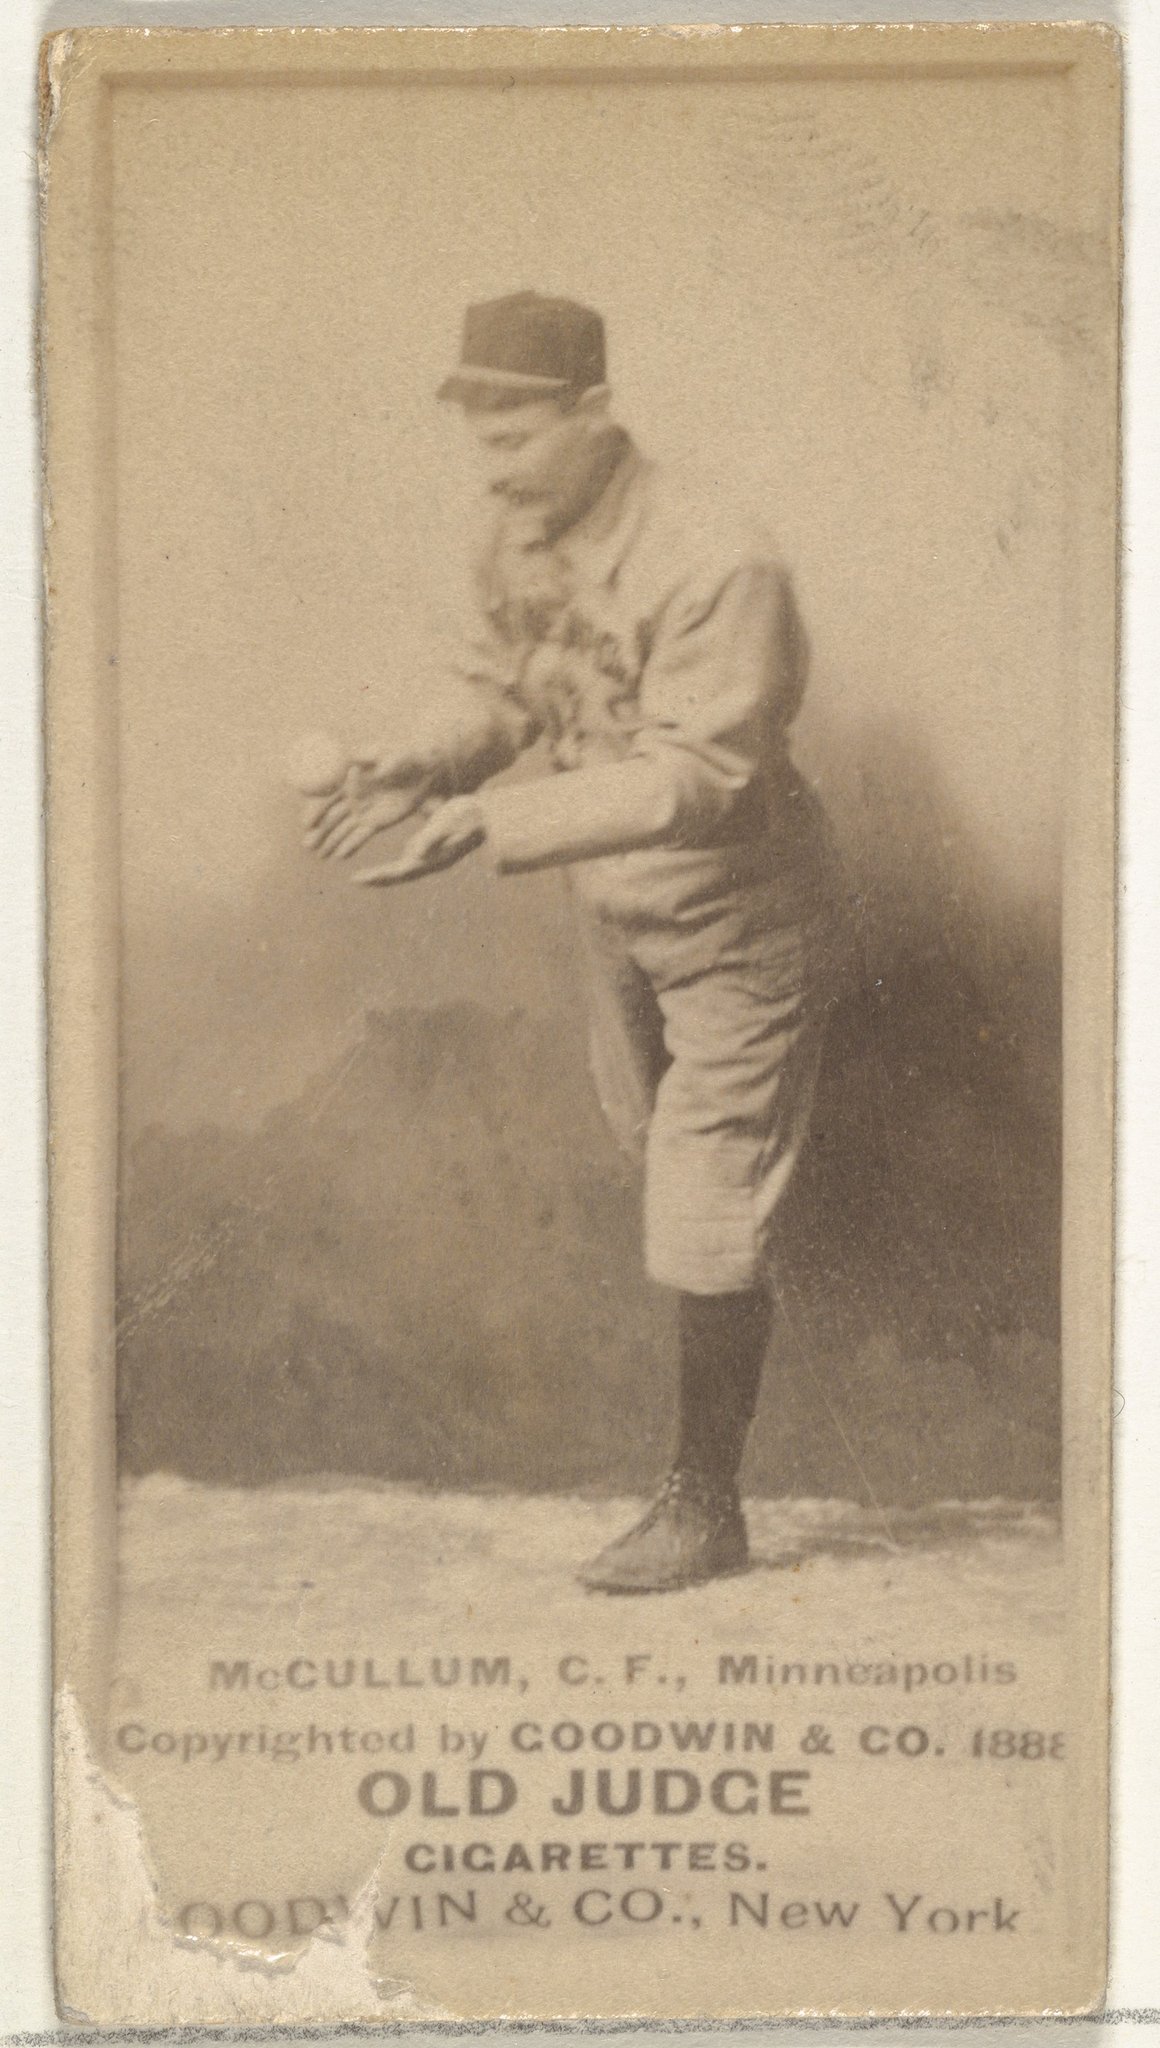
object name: baseball card, photograph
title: Thomas McCallum, Center Field, Minneapolis, from the Old Judge series (N172) for Old Judge Cigarettes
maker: goodwin & company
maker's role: publisher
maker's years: 1850-1950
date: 1888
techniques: albumen silver print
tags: men,portraits,baseball,athletes